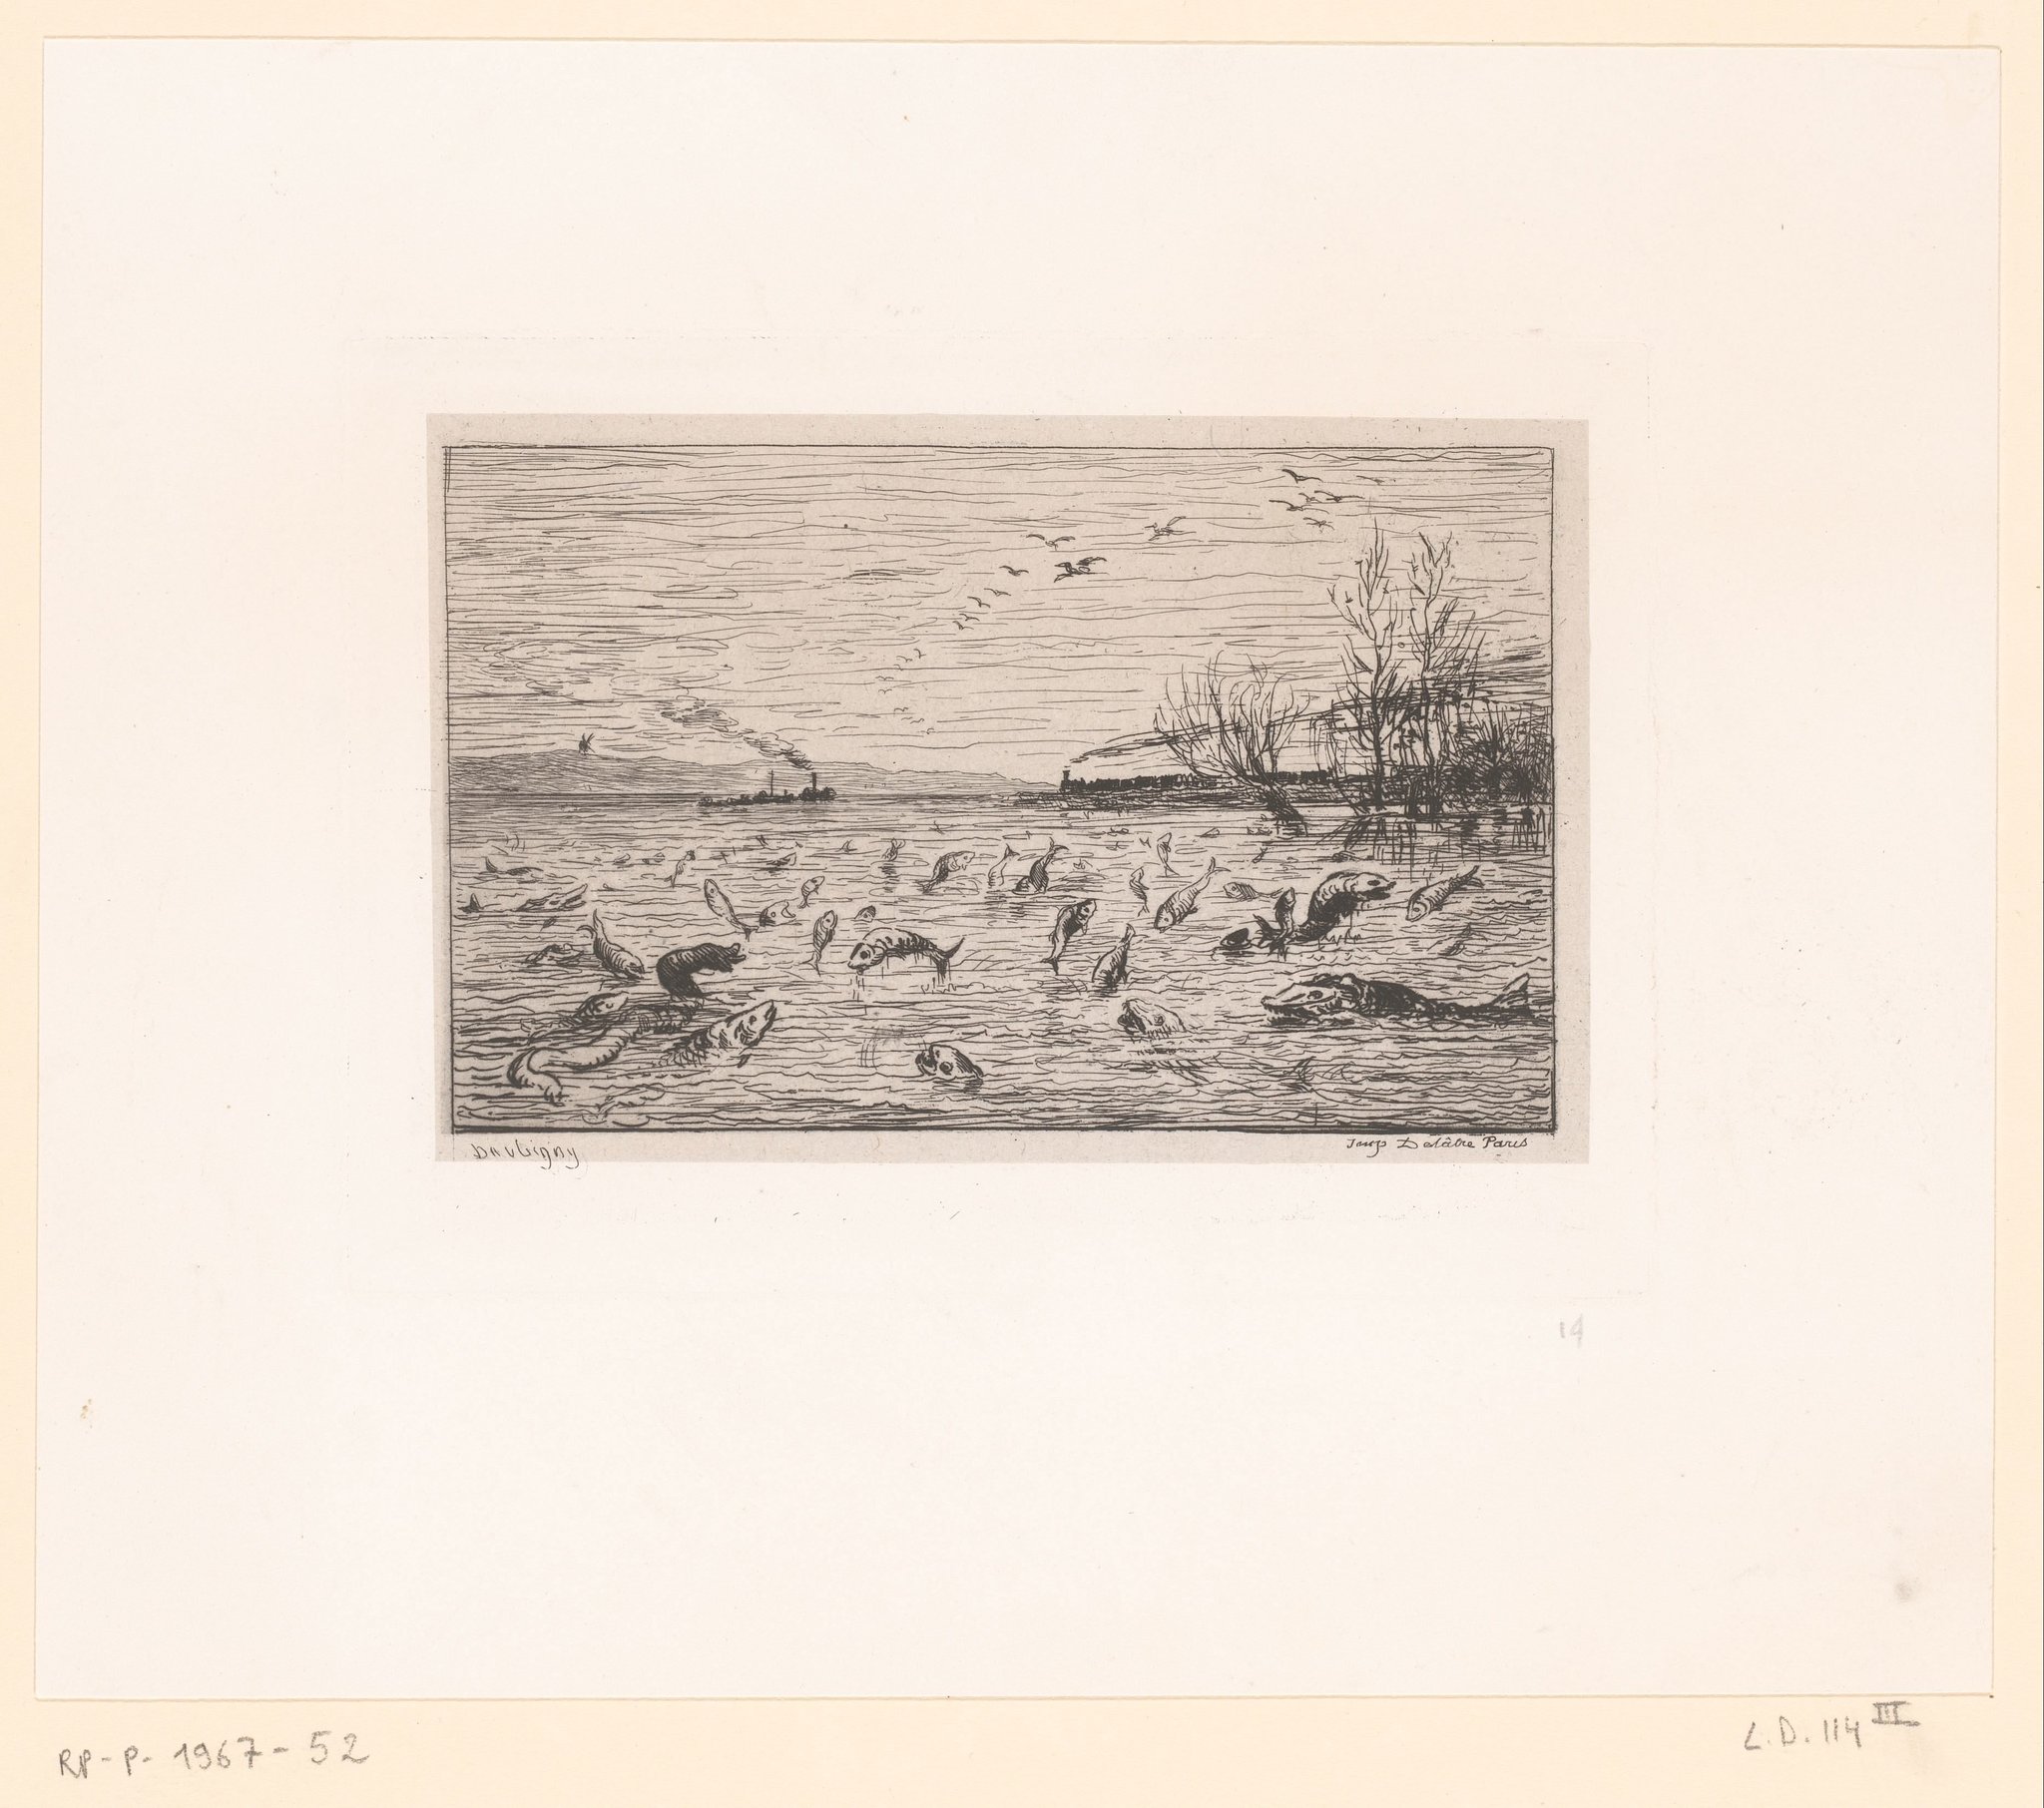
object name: print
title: Voyage en bateau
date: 1867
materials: paper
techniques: drypoint, etching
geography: france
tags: jumping up, fishes, lake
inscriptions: collector's mark: Lugt 2760, collector's mark: Lugt 2228